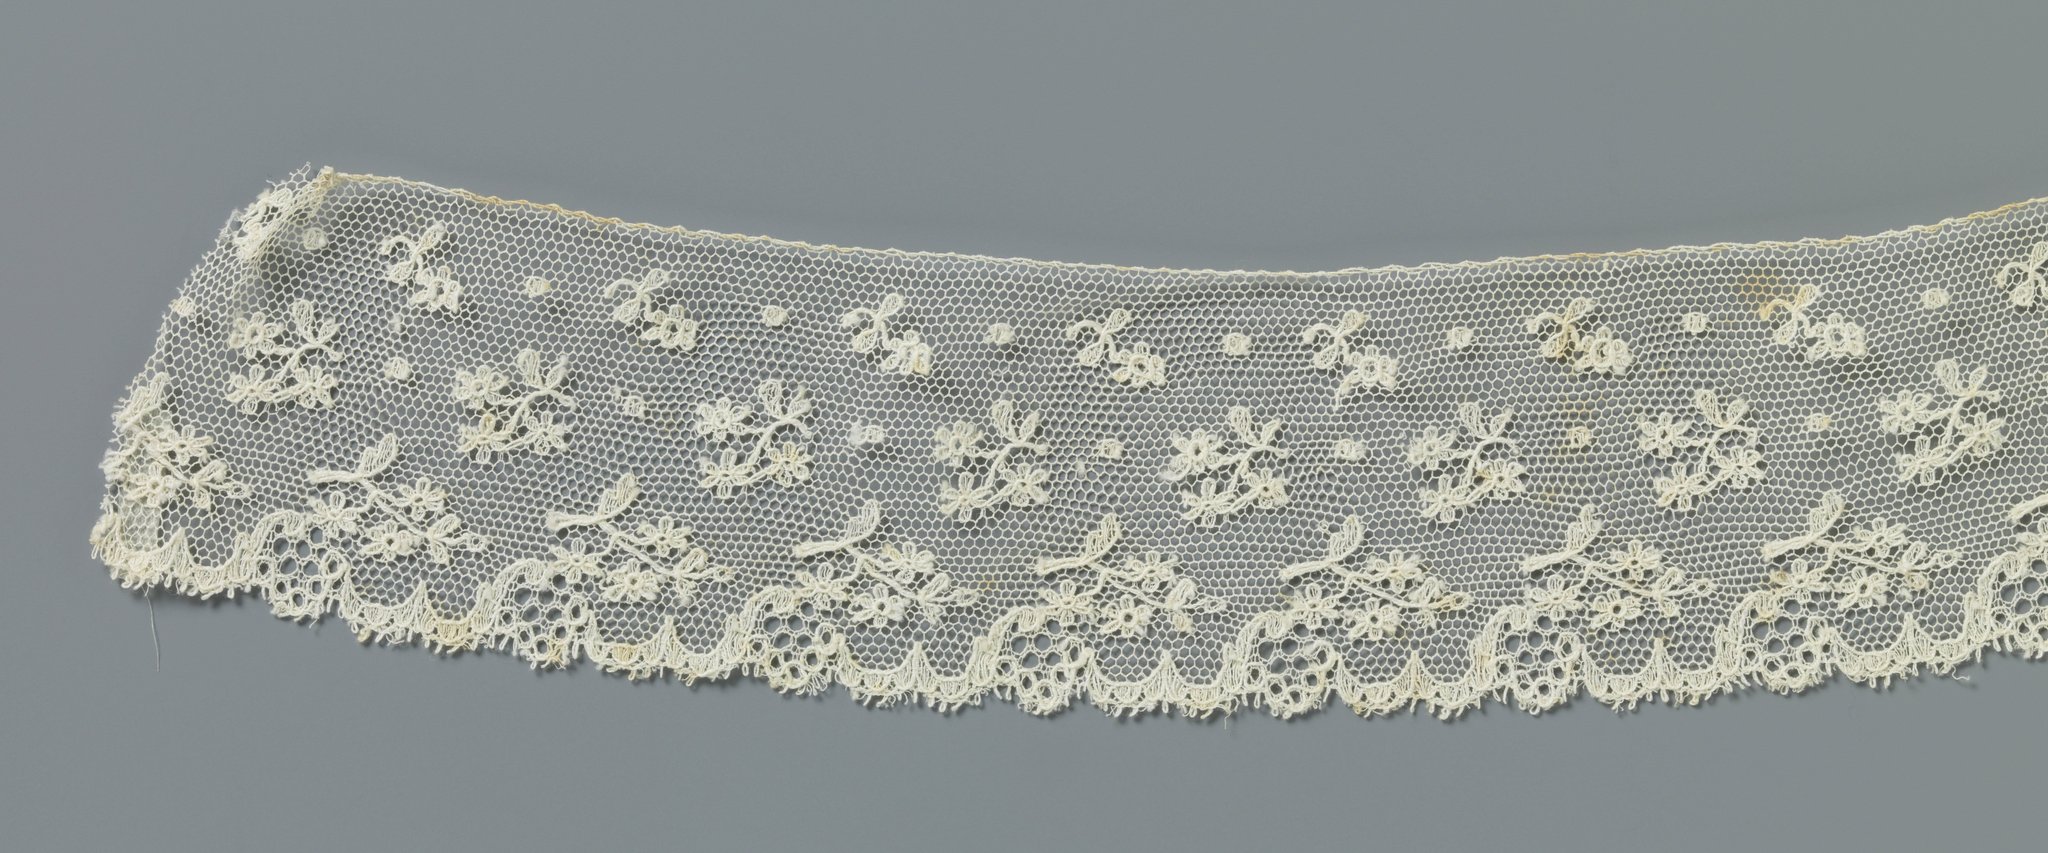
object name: strip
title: Strook machinale kant met drie rijen bloemtakken en w-vormige motiefjes langs de onderzijde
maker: Anonymous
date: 1850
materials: cotton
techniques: lace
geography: france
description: Strook naturelkleurige machinale kant: machinale Alençon-kant. De strook is iets gebogen van vorm. Het zich herhalende patroon bestaat uit drie rijen bloemtakken met steeds één moesje tussen de bloemtakken in de bovenste twee rijen. De opeenvolgende bloemtakken in de bovenste rij bestaan uit één bloem met twee blaadjes. In de middelste rij hangen er steeds drie bloemen aan de bloemtakken. De onderste bloemtakken zijn het grootst met drie bloemen en een bloemknop in de top. Langs de onderrand liggen w-vormige motiefjes waartussen cirkeltjes gemaakt met een siergrond, een machinale rozengrond. De motieven zijn voorzien van contourdraden en zijn met elkaar verbonden door een zeshoekige maasgrond, een machinale Alençon-grond. De bovenzijde van de strook is recht afgewerkt. De flauw geschulpte onderzijde komt voort uit het patroon met de w-vormige motiefjes en cirkeltjes en is afgewerkt met picots.